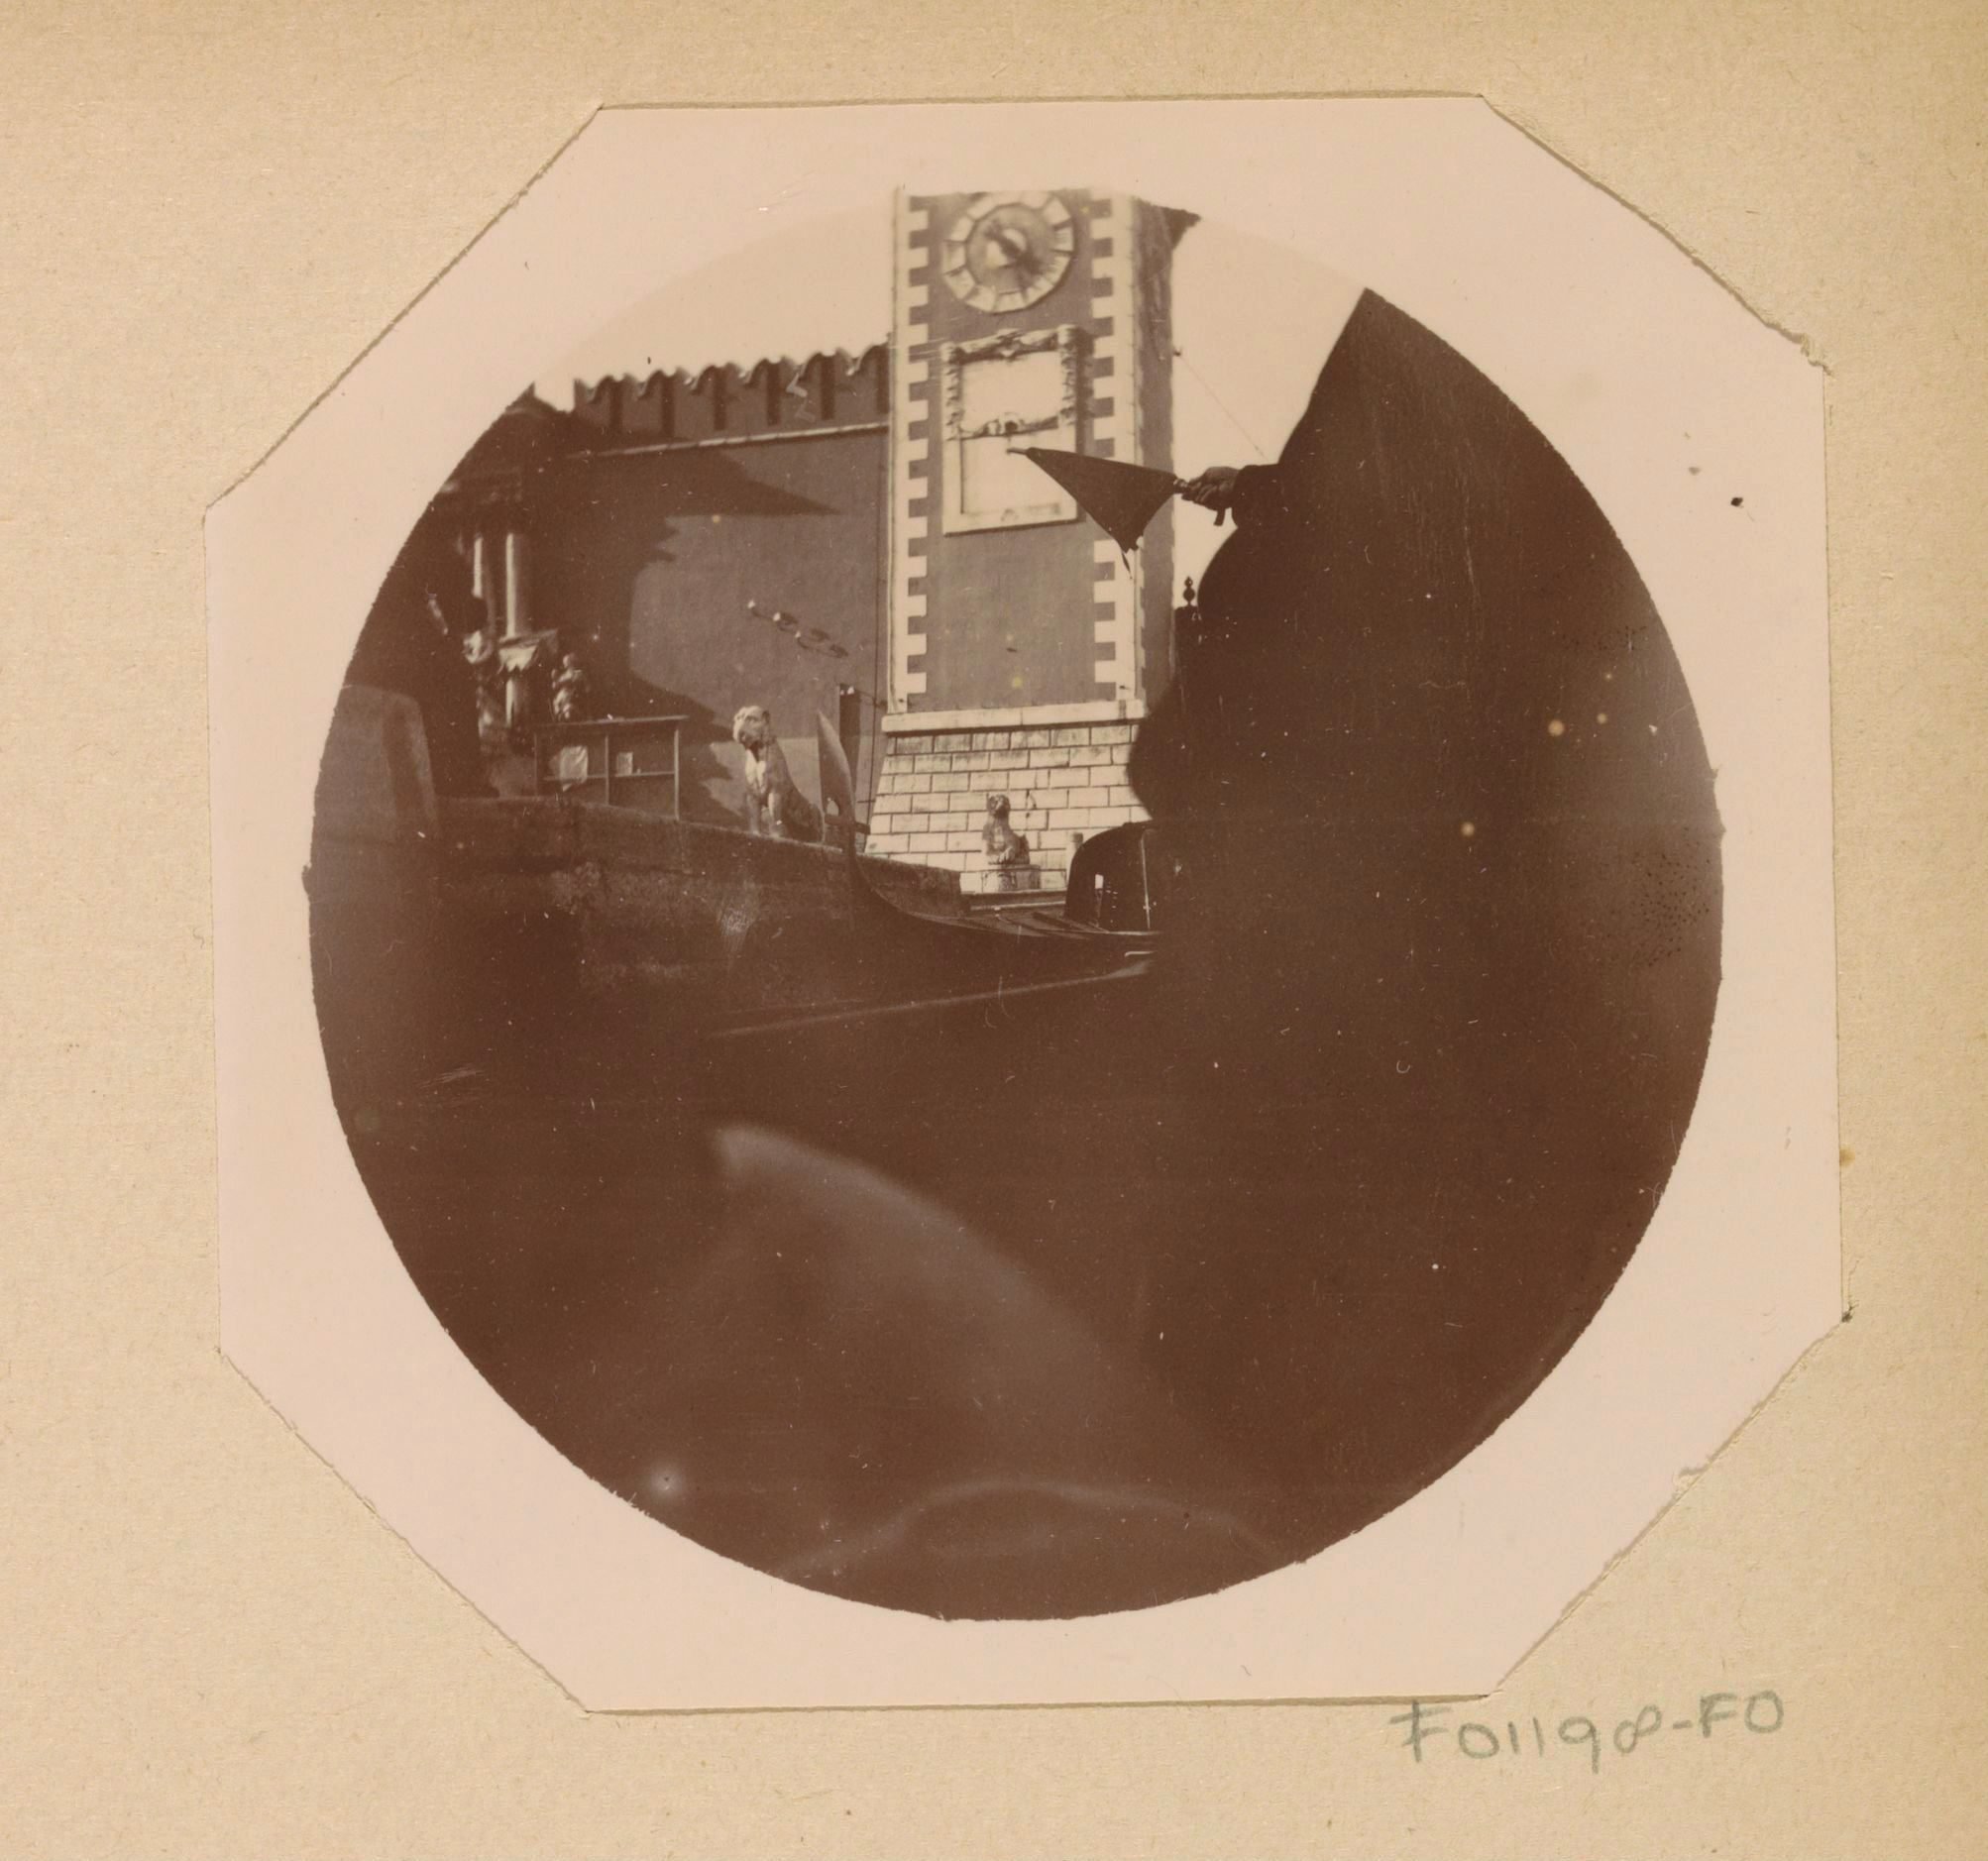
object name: photograph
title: Uitzicht vanuit een gondel in Venetië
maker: johanna margaretha piek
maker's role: fotograaf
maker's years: 1870-1947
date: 1889-1893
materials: paper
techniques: gelatin silver print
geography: venice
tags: gondola, venice